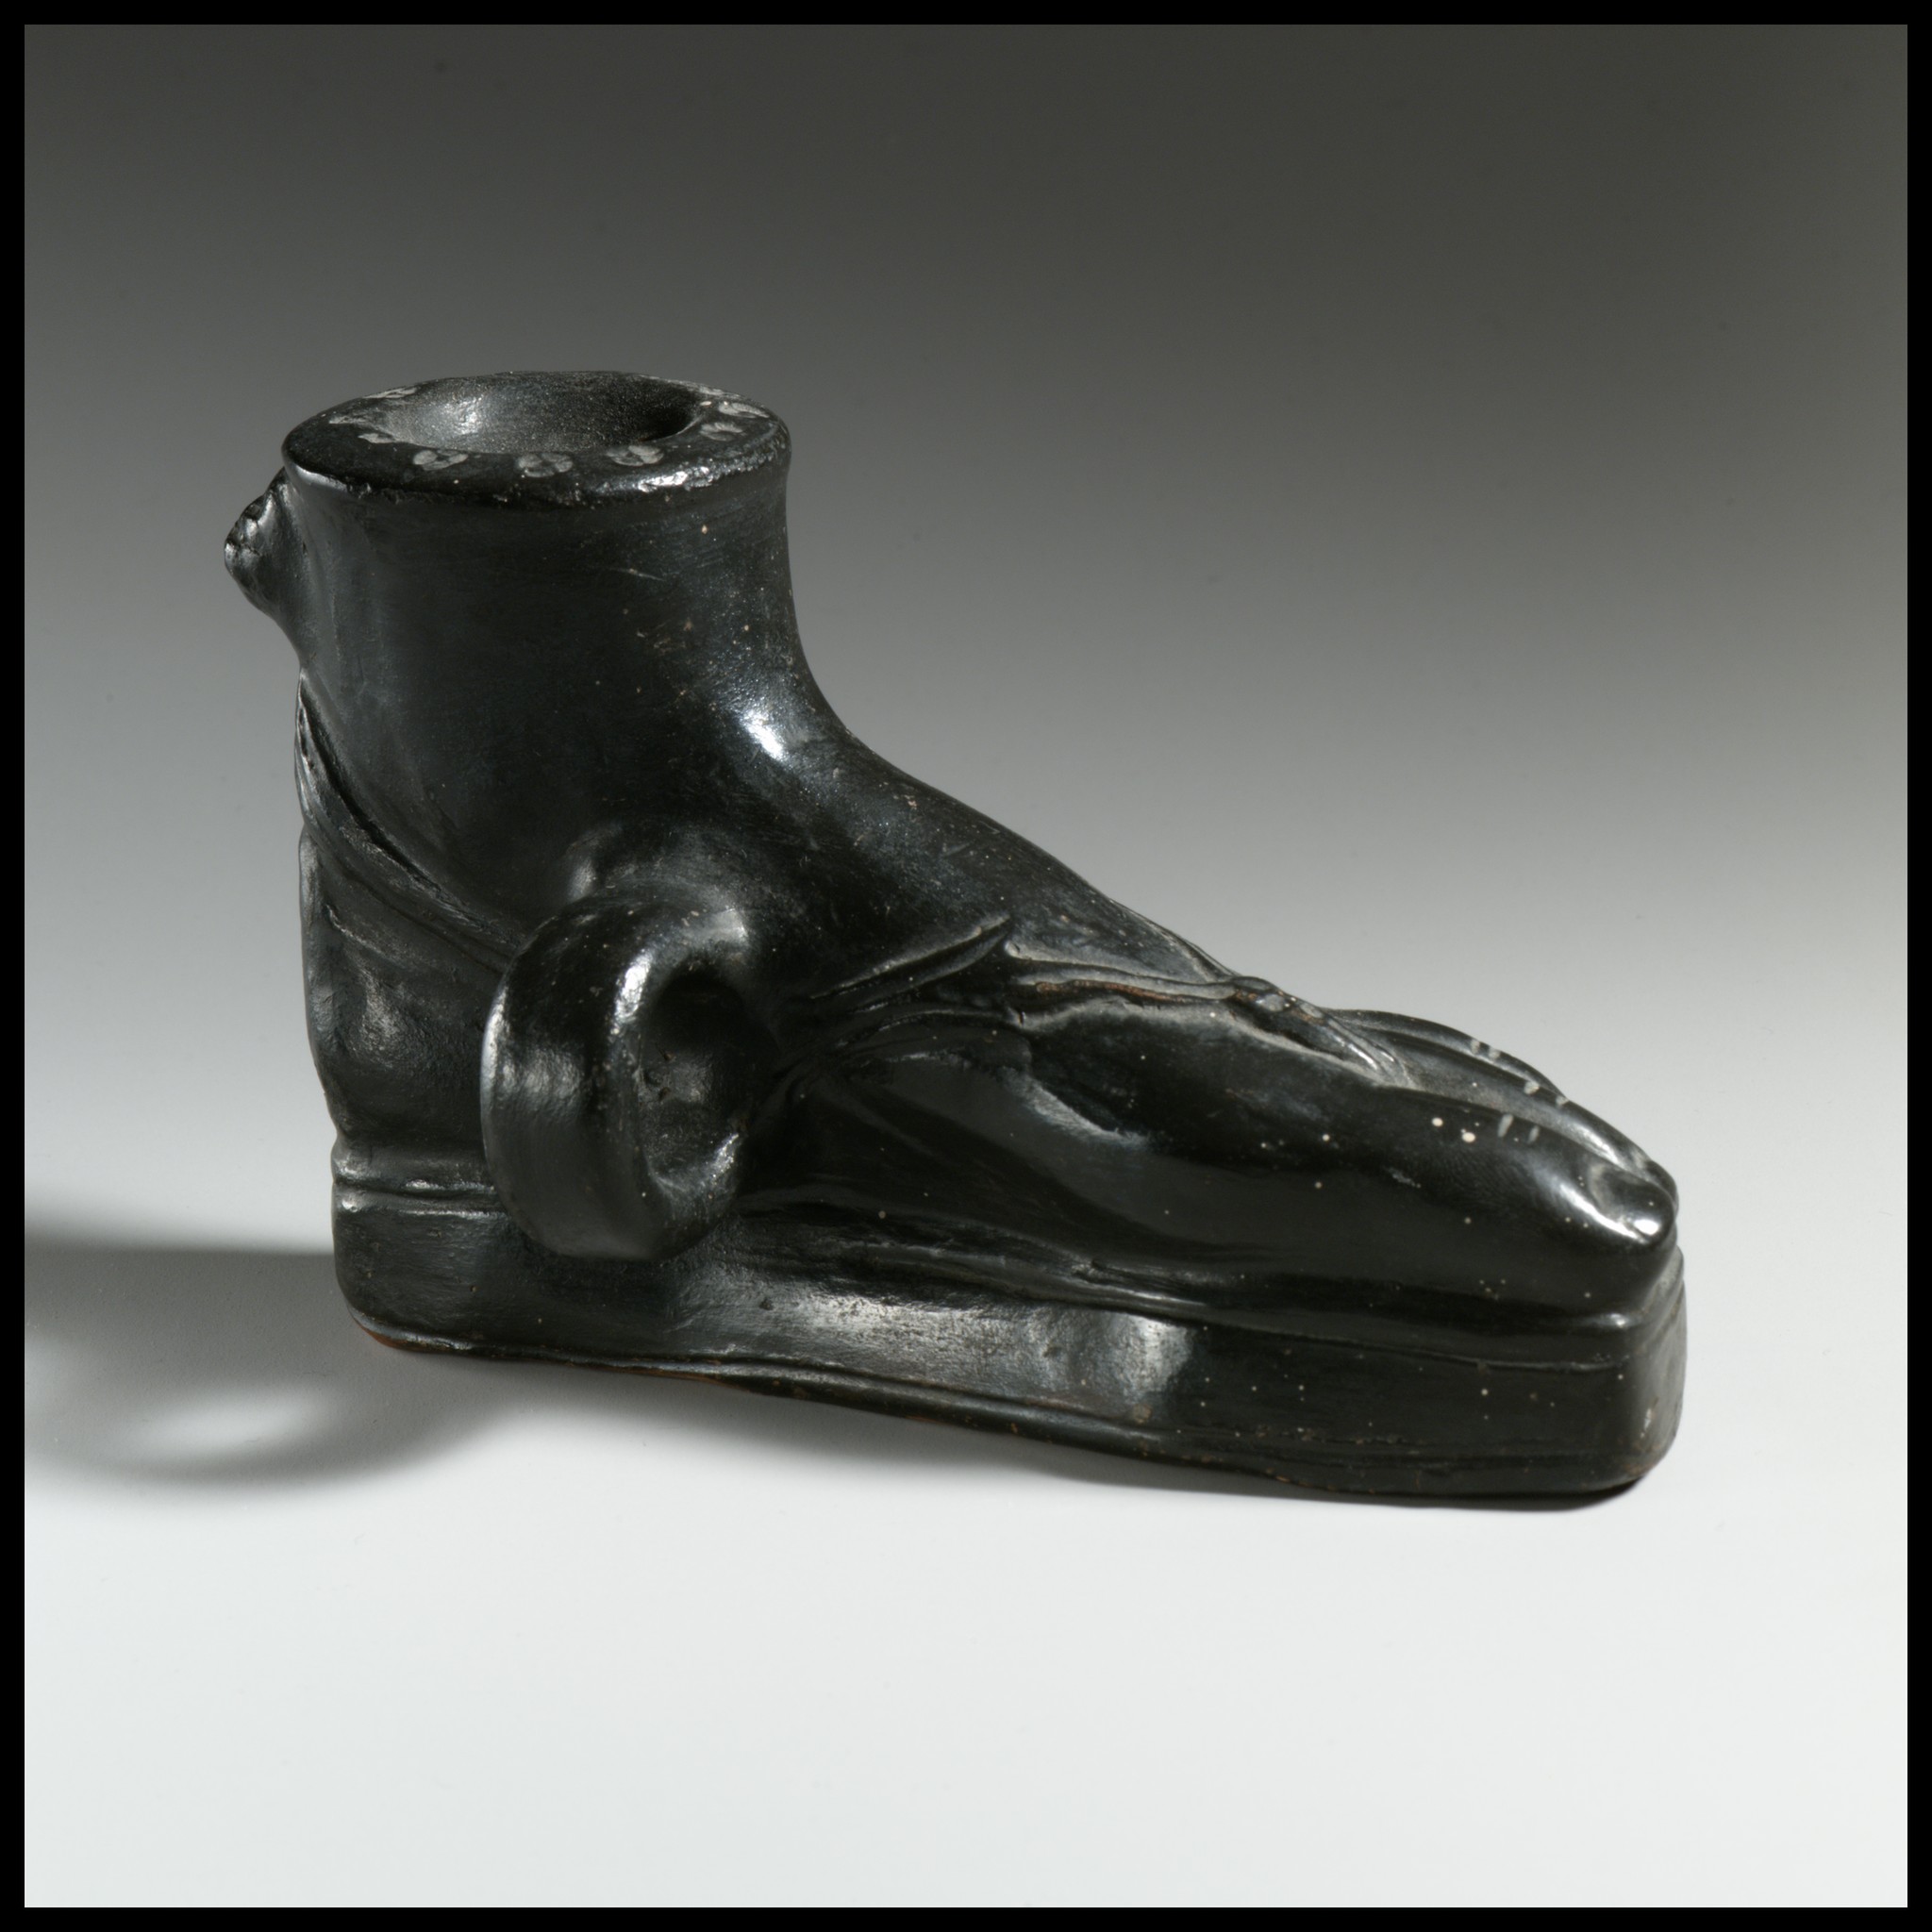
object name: guttus in the form of a sandled foot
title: Terracotta guttus (flask with handle and spout)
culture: greek or south italian or campanian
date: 400-301 BCE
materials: terracotta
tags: feet